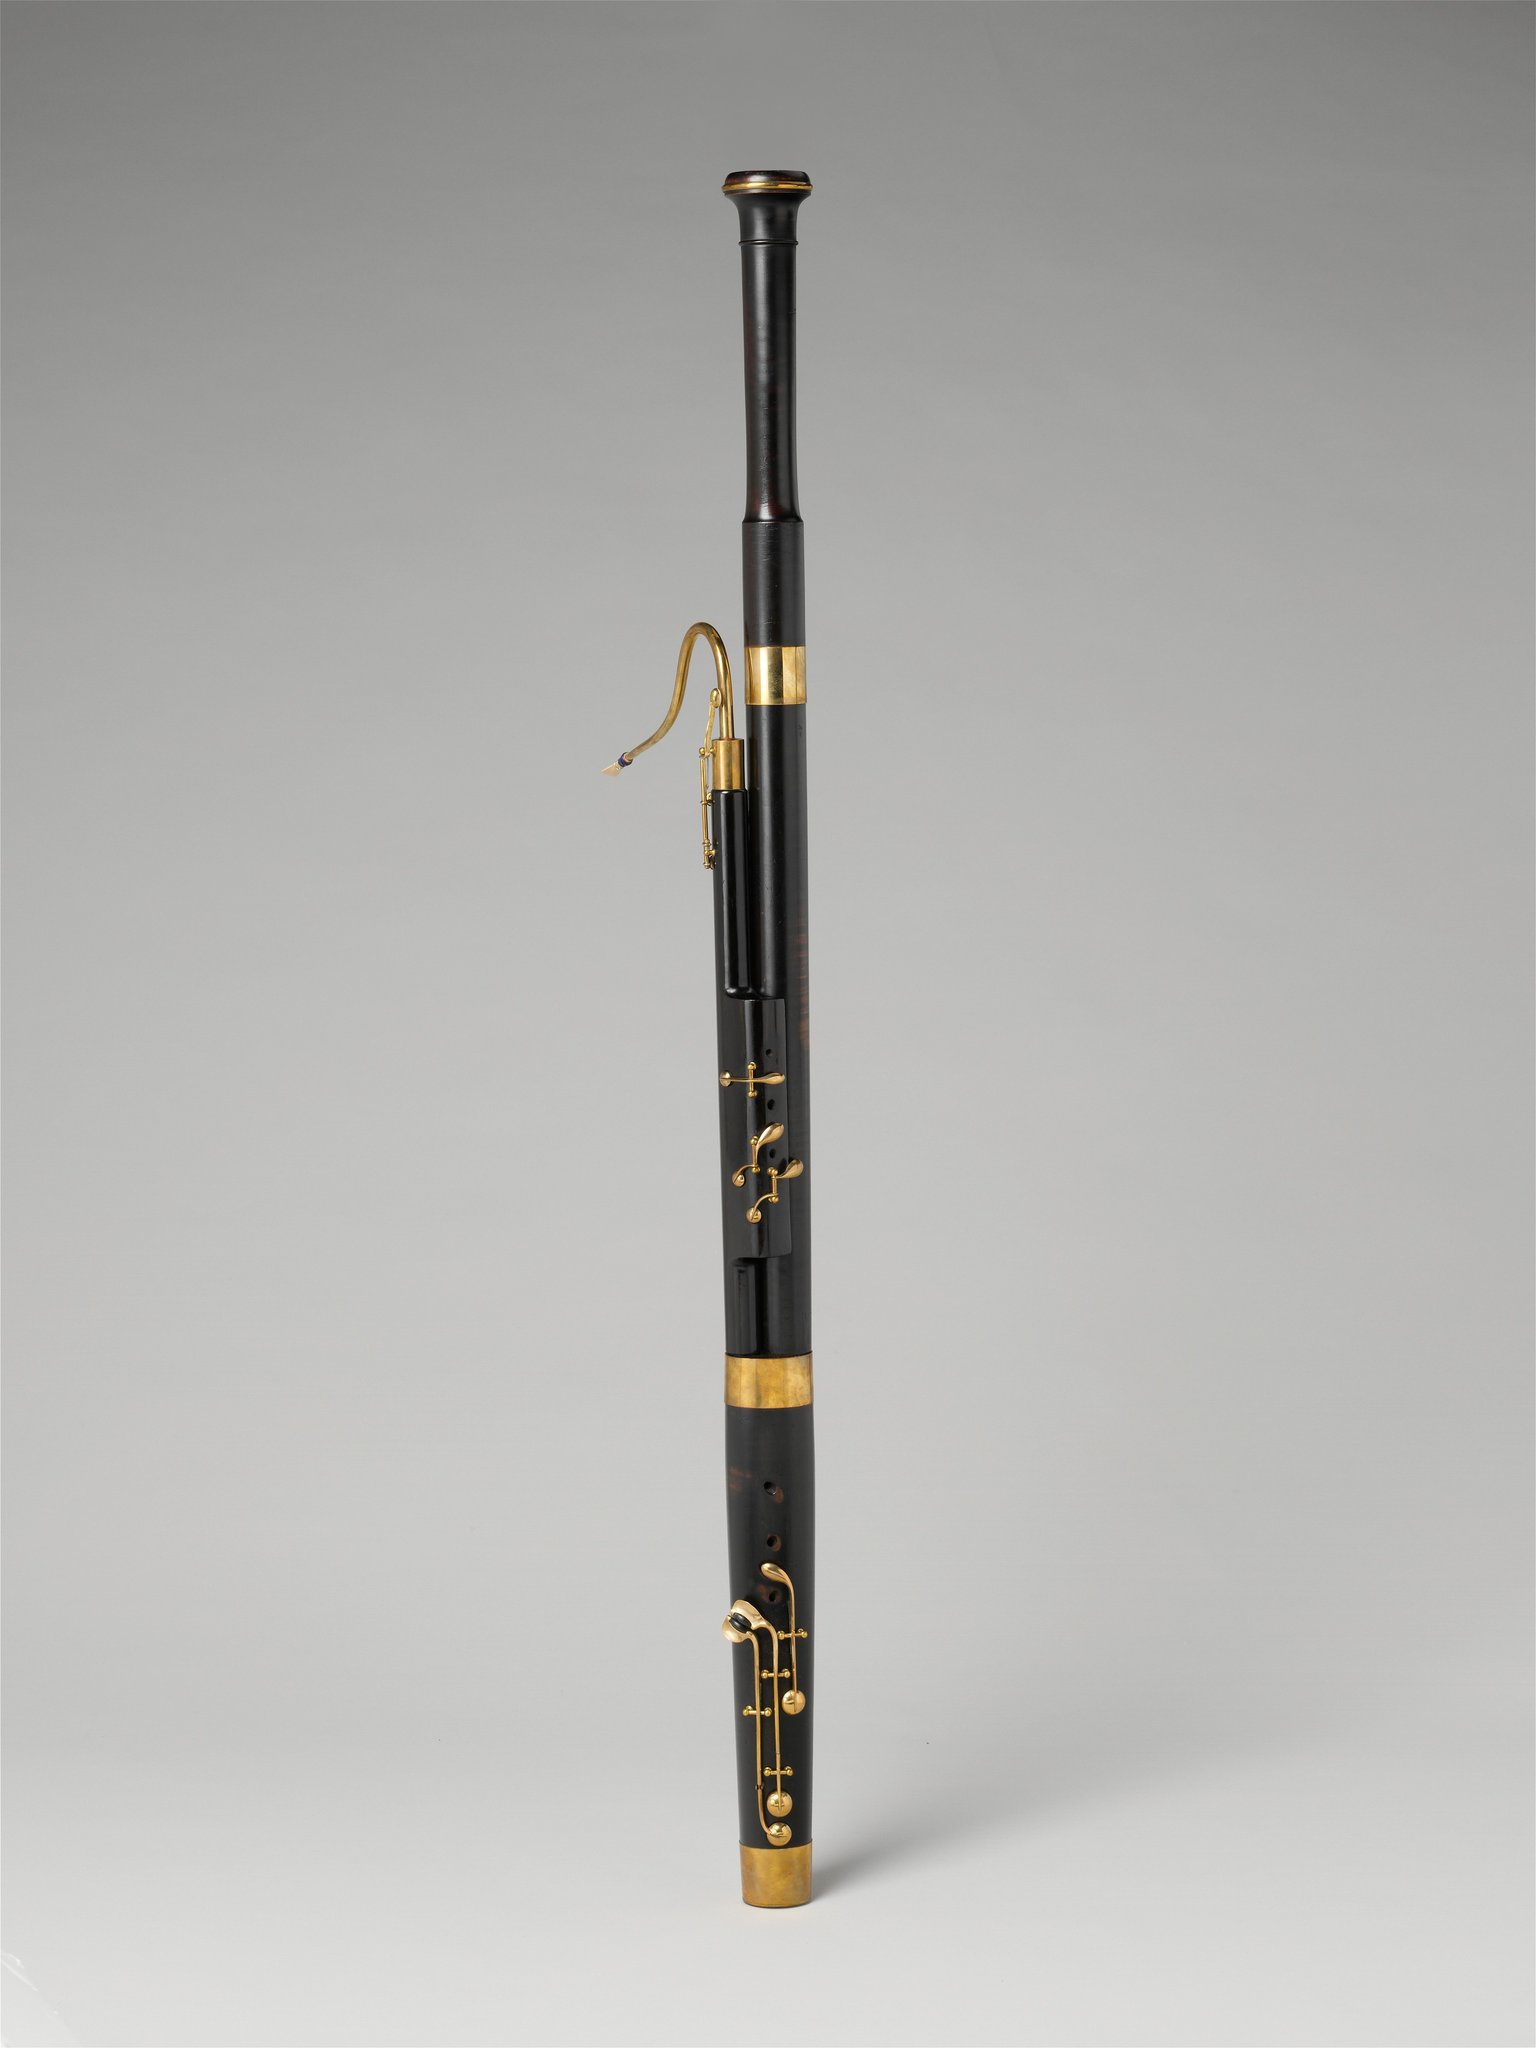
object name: bassoon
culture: french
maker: frederic triebert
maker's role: maker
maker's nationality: french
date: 1870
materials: brass, gold, wood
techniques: wash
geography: france